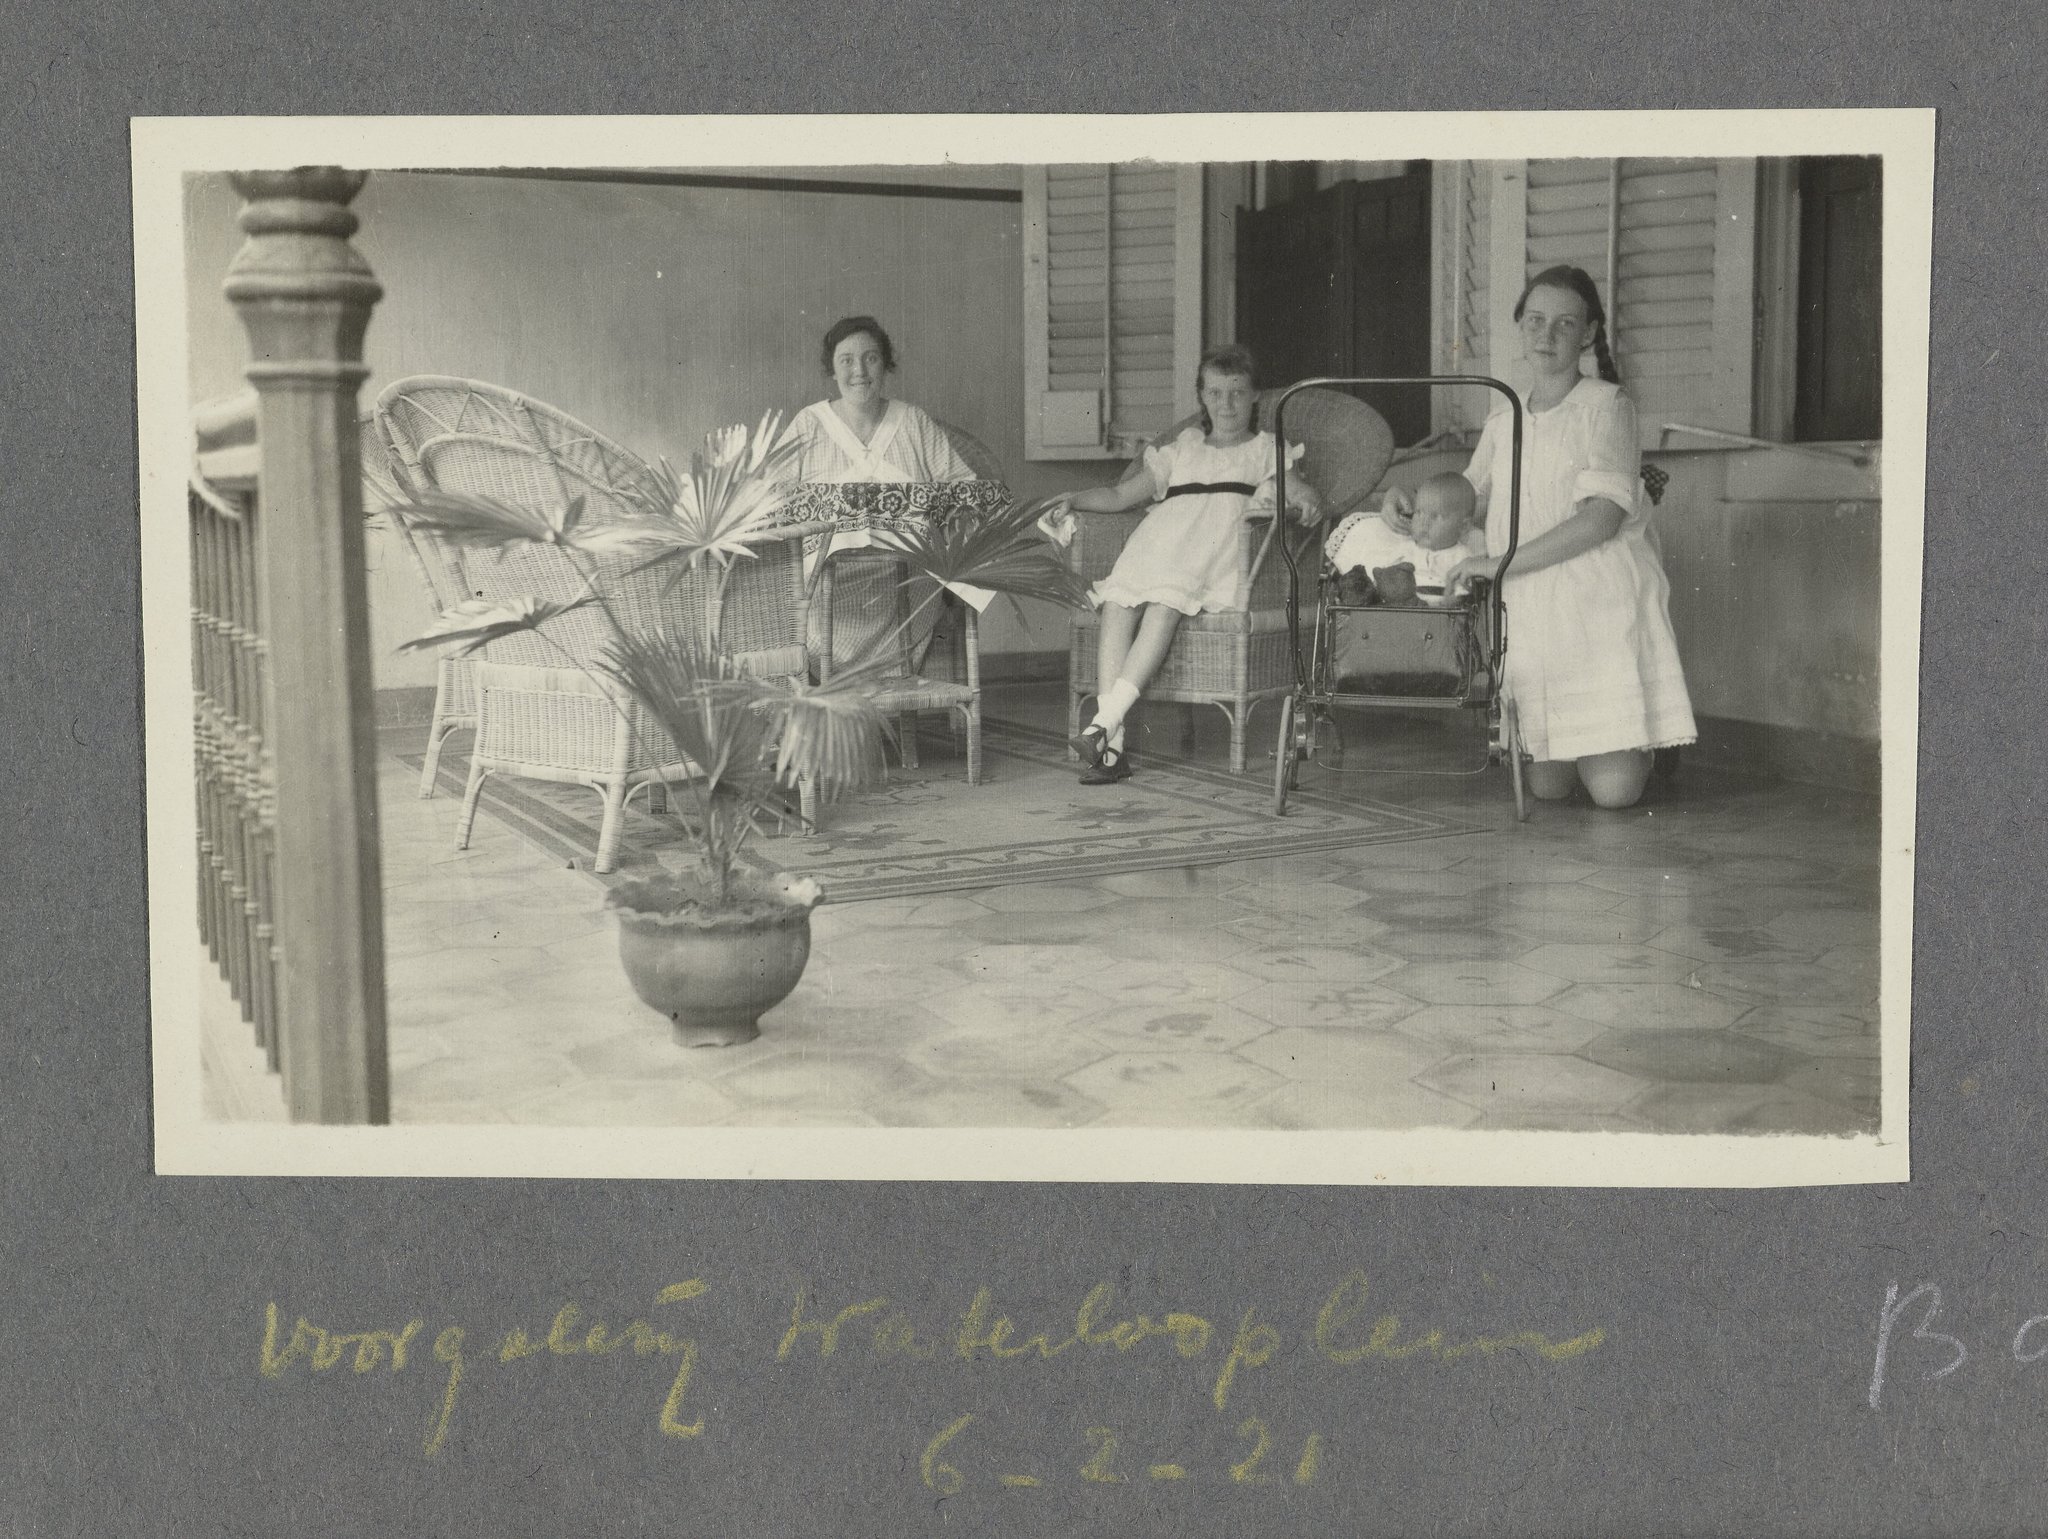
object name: photograph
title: Groepsportret van Tine Kleiterp-Vermeulen (links), Corrie en Els Bakker en baby Klaas Kleiterp op een galerij aan het Waterlooplein in Batavia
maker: klaas kleiterp (i)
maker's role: arts, officier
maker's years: 1892-1943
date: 1921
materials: paper, photographic support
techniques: gelatin silver print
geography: batavia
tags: baby-carriage, pram, perambulator, child, mother and baby or young child, dutch east indies, the, batavia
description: Onderdeel van Fotoalbum van de familie Kleiterp-Vermeulen met opnames van de kinderen Klaas en Tiny in Nederlands-Indië.